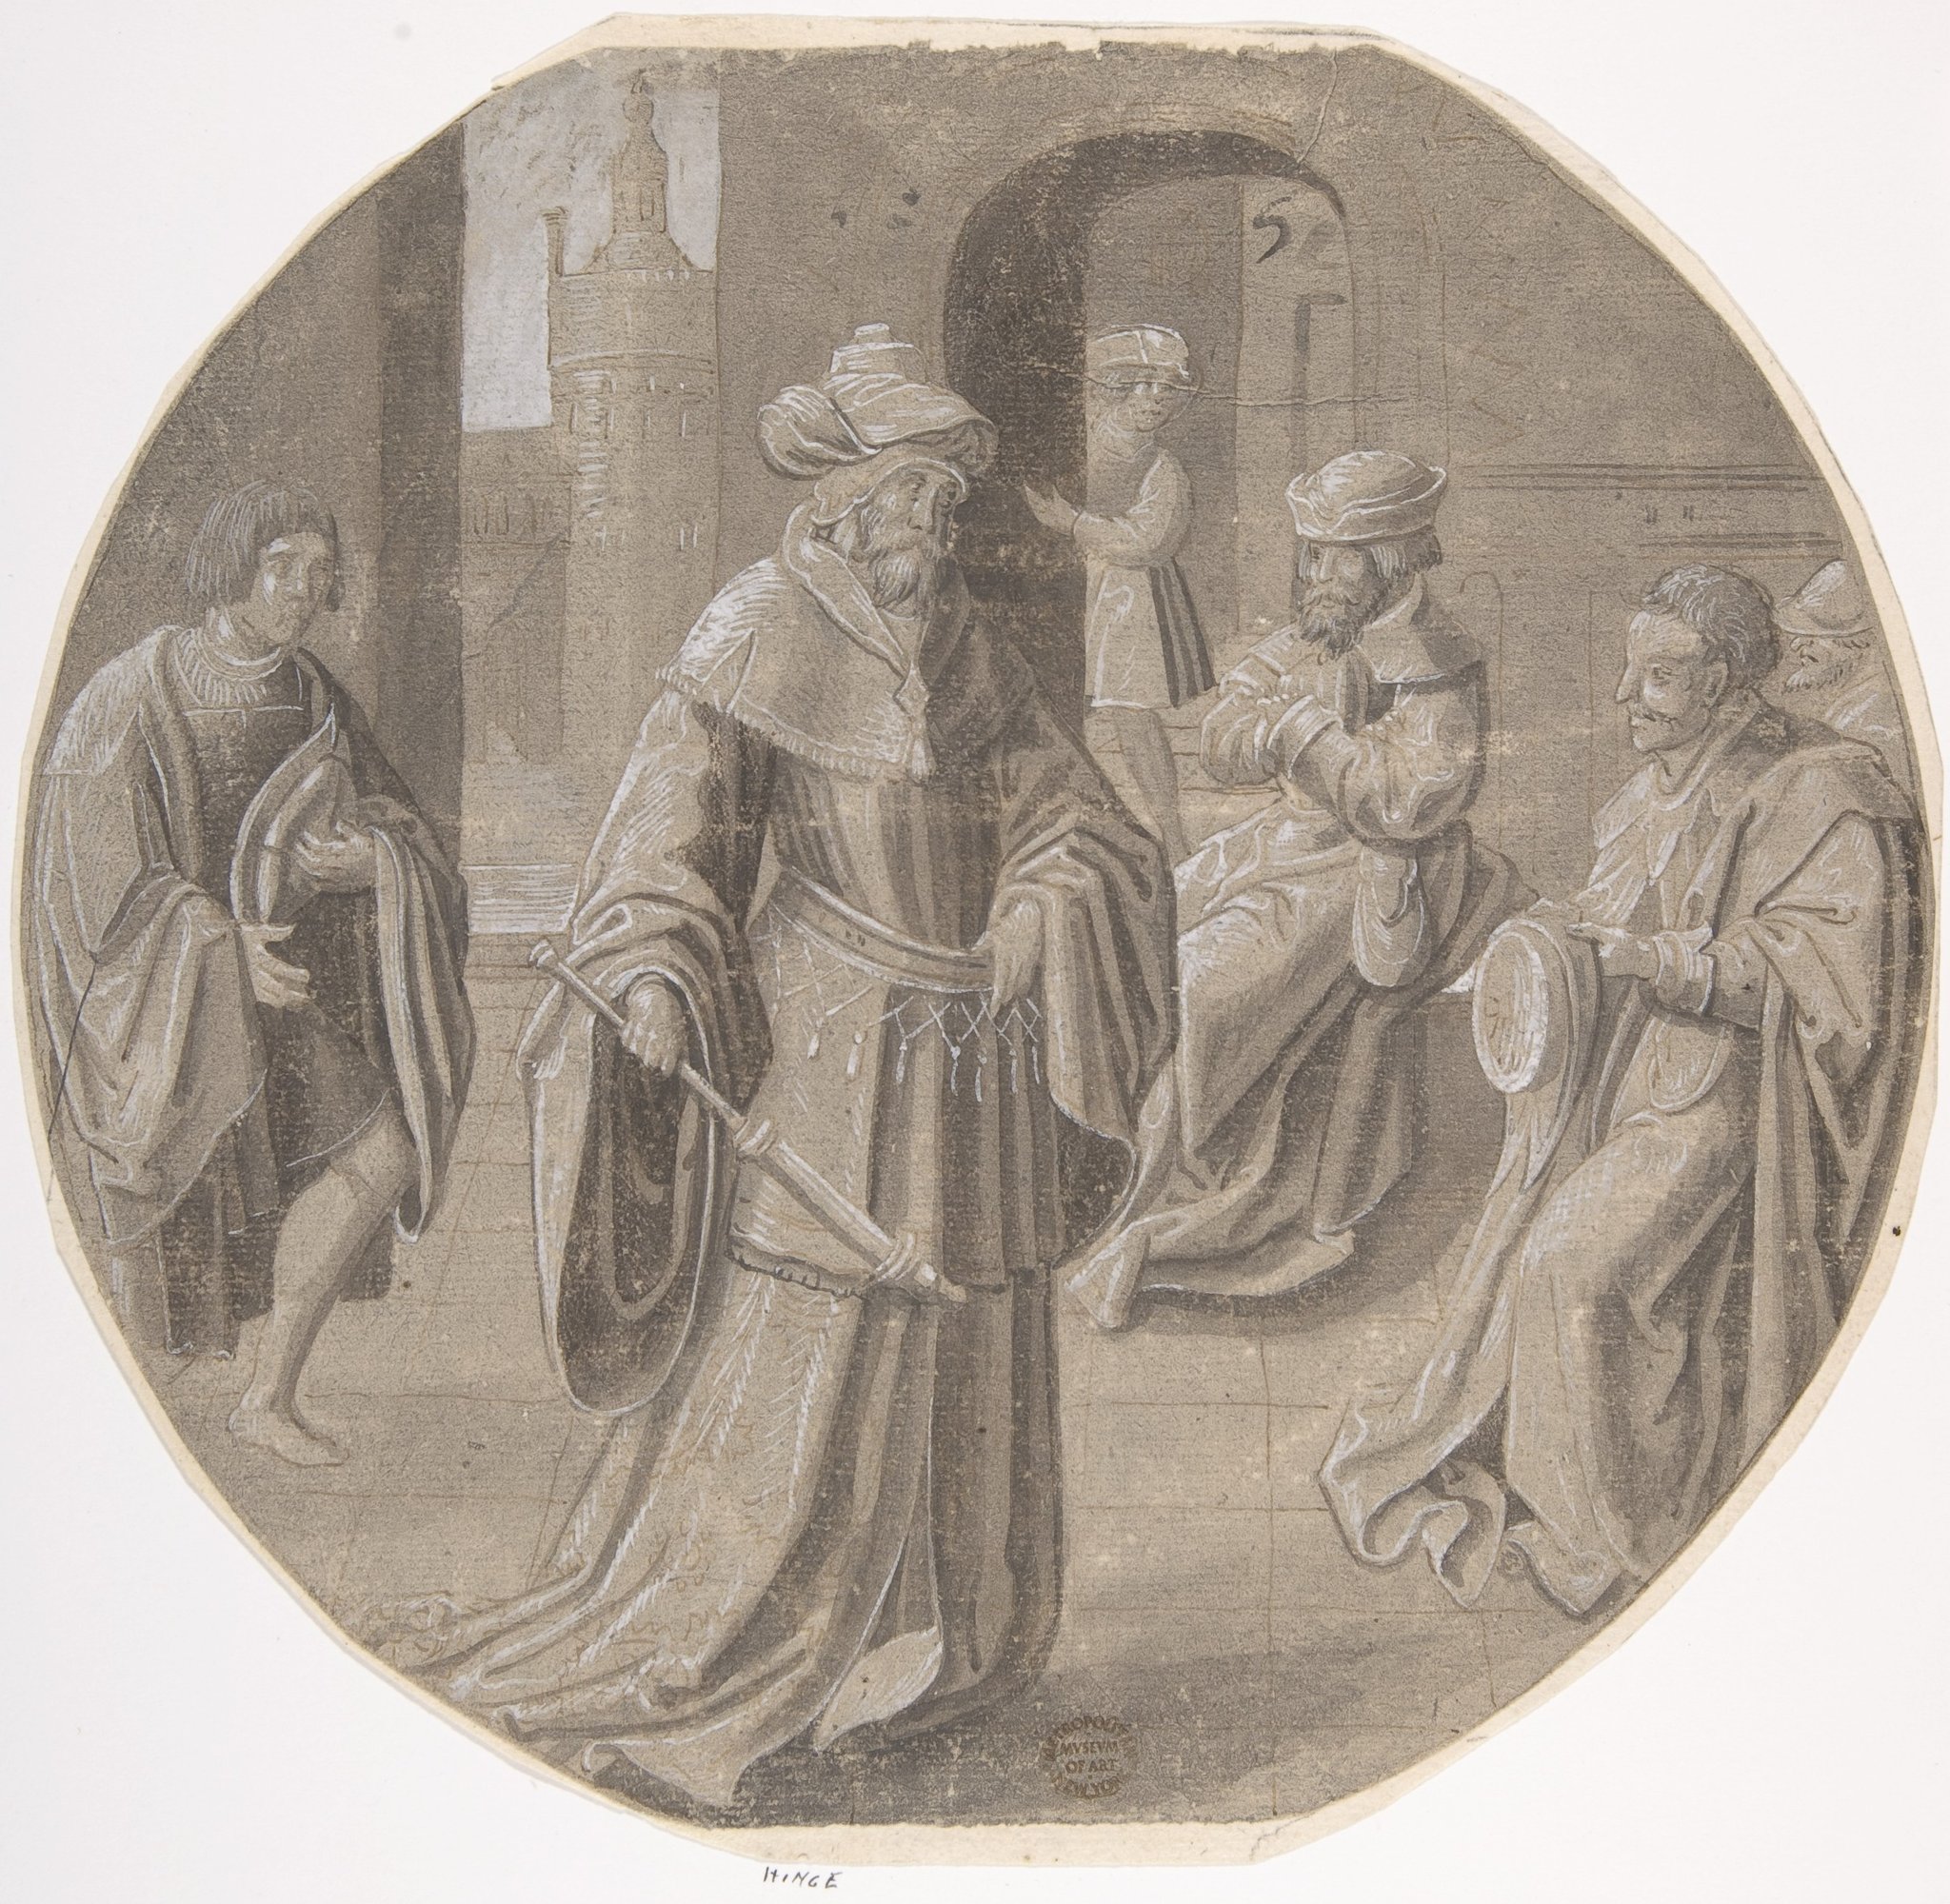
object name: drawing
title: The Greatness of Mordecai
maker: pseudo-aert ortkens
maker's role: artist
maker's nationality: netherlandish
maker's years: 1510-1540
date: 1501-1566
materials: ink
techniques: brush, highlighting, pen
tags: men